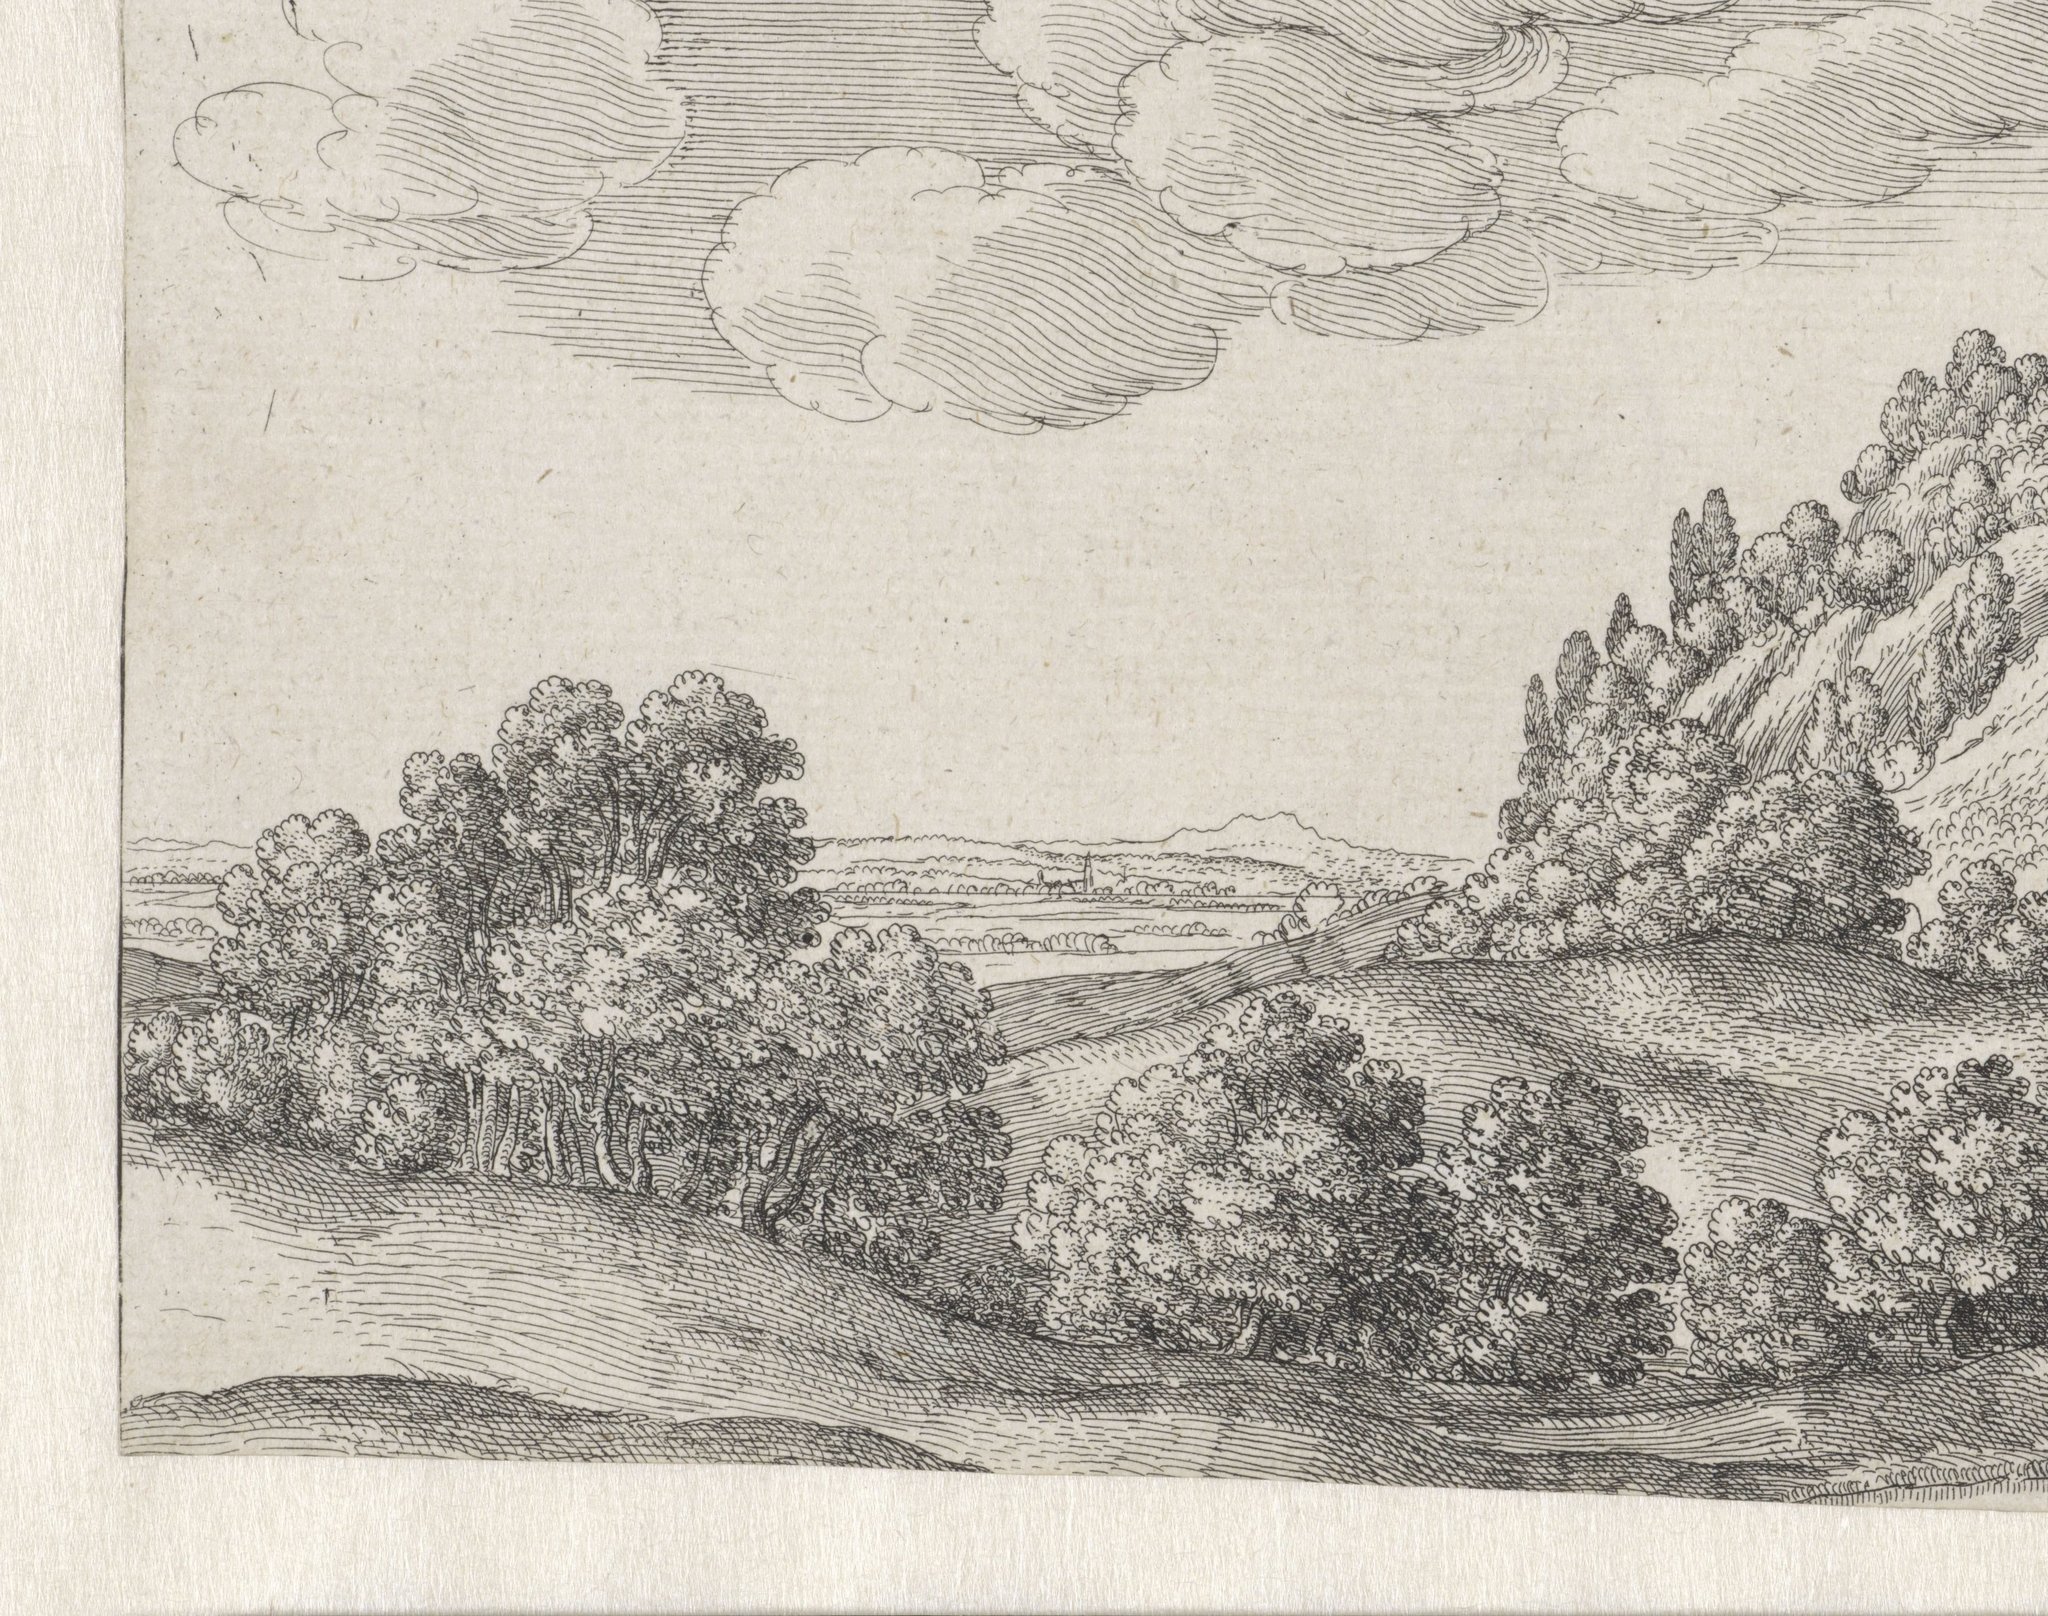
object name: print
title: Landschap met een kasteel op een heuvel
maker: wenceslaus hollar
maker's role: draughtsman, print maker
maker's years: 1607-1677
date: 1625-1677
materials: paper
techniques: etching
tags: landscape with tower or castle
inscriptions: collector's mark: Lugt 2228